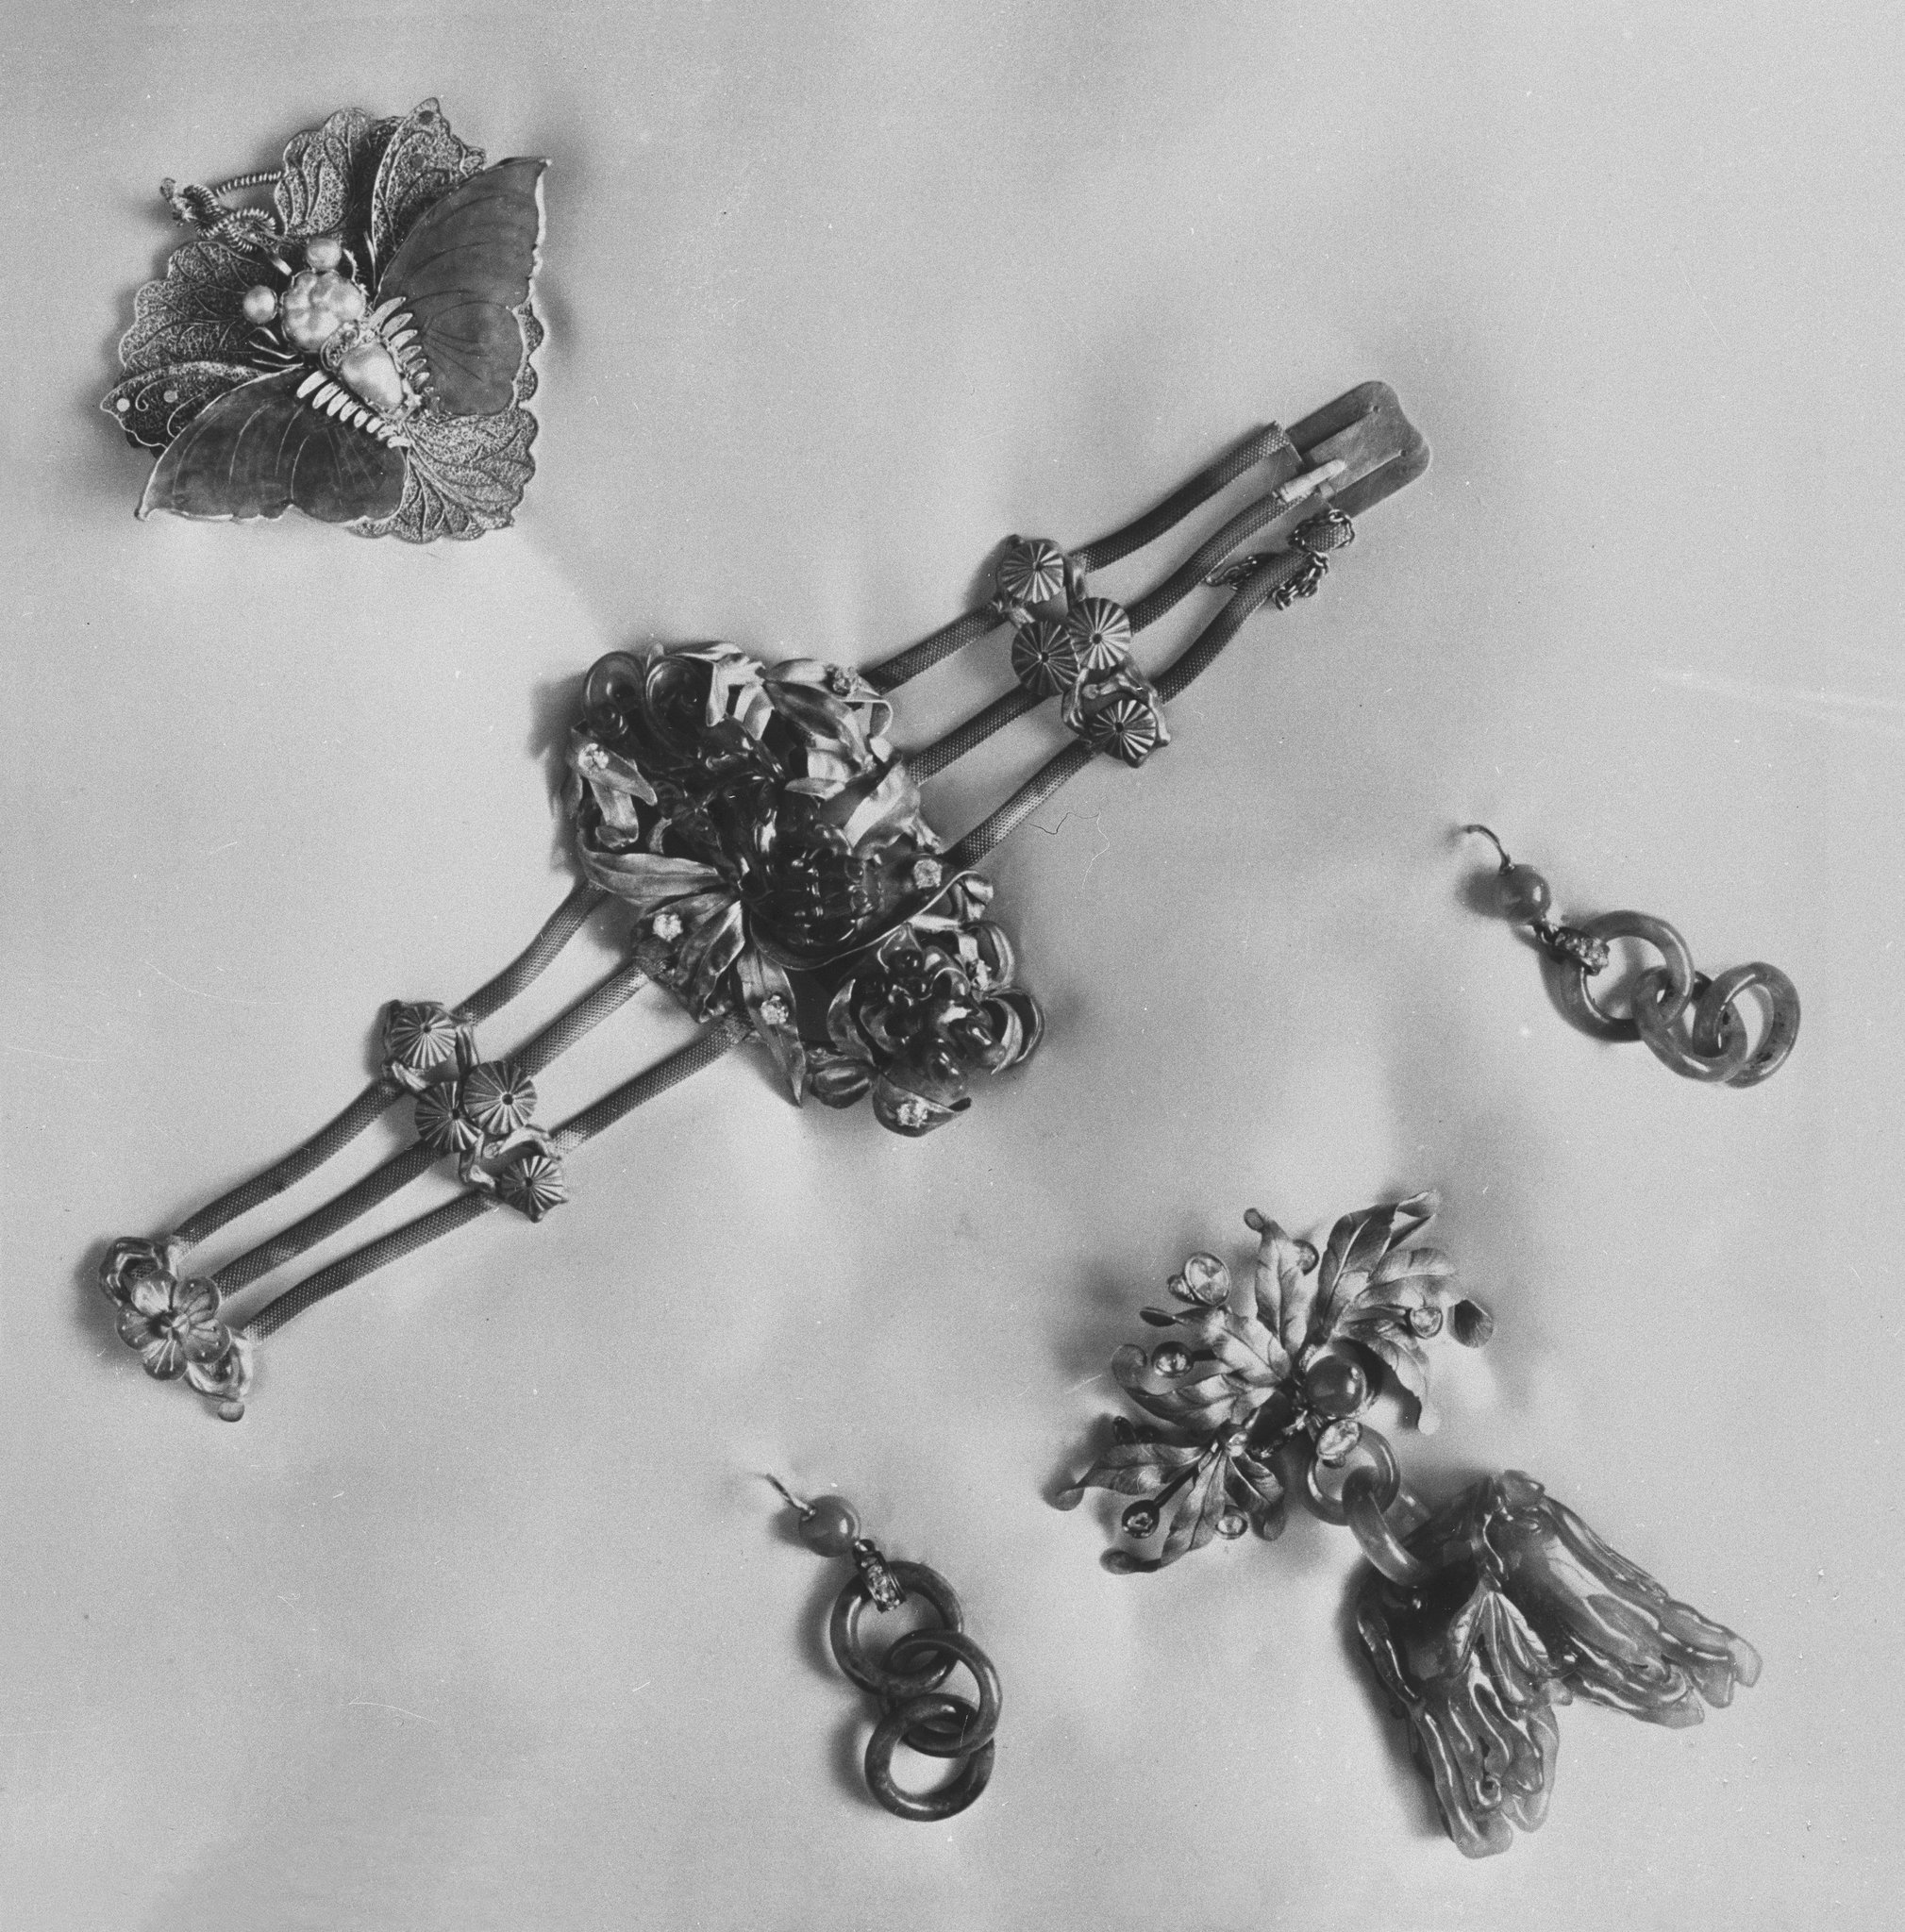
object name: jewellery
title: Jewelry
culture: chinese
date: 1736-1795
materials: gemstone, jade